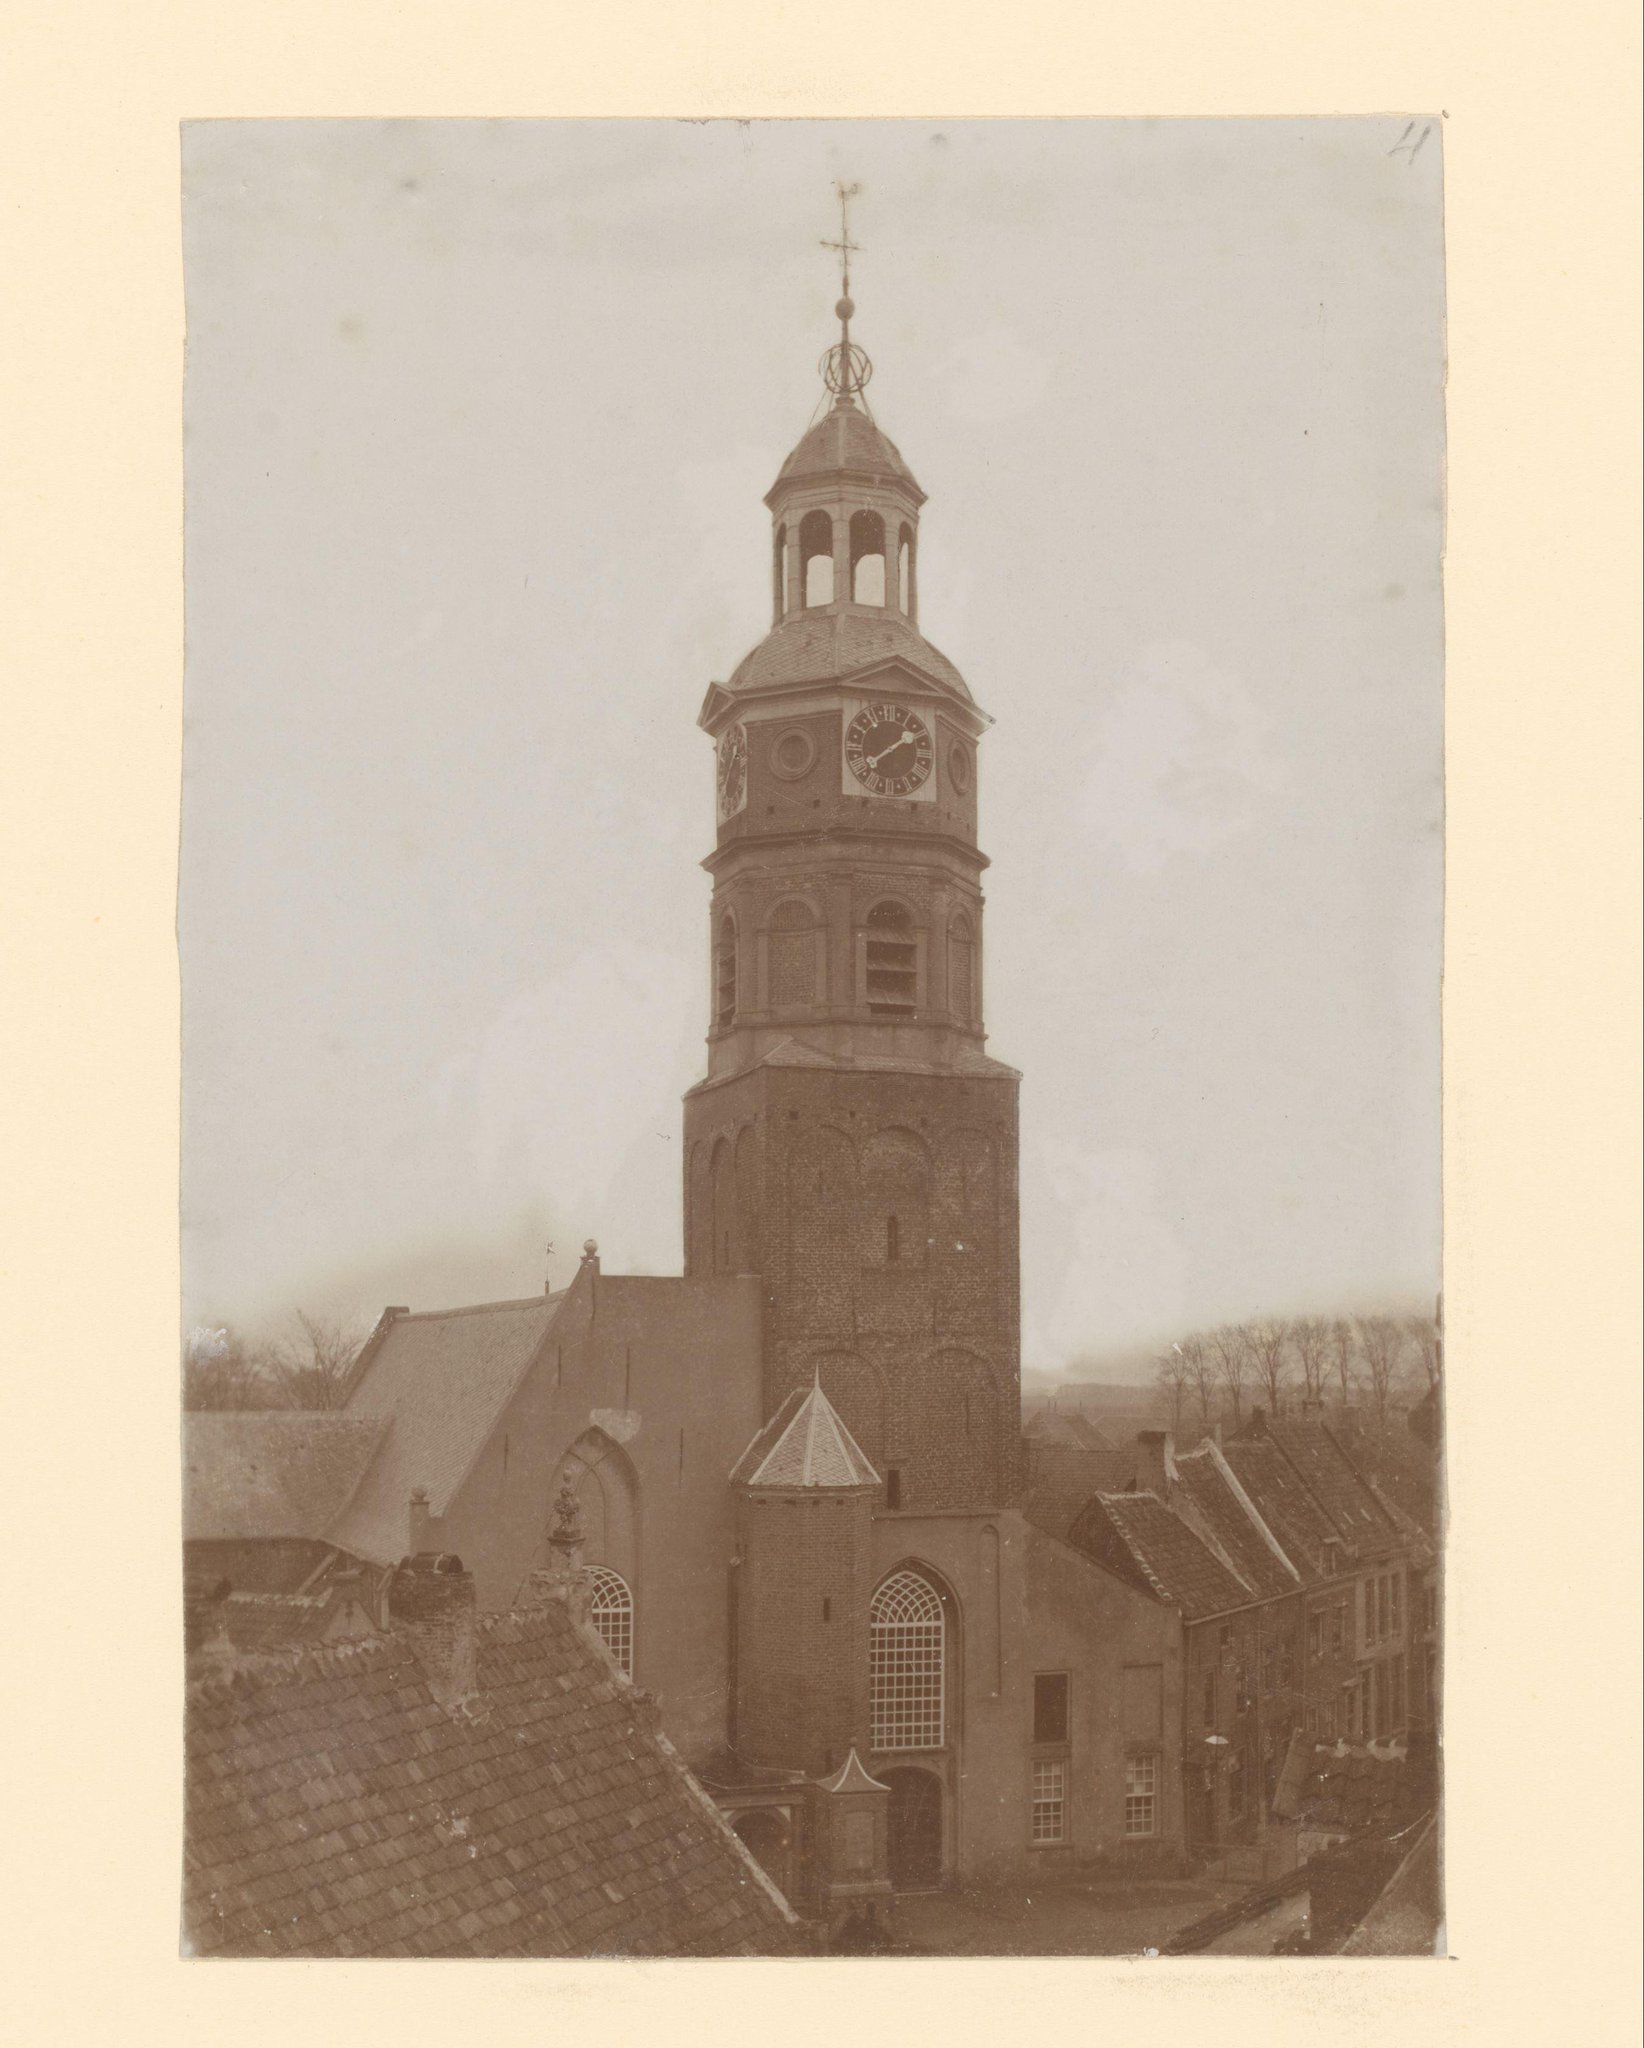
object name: photograph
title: Toren van de Sint-Lambertuskerk te Buren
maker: Anonymous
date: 1890-1920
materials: cardboard, photographic support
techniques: collodion silver print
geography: buren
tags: parts of church exterior and annexes: tower, buren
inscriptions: annotation: ‘N.H. Kerk/ Buren’, annotation: ‘Toren v/d Ned Herv. gem/ te Buren (H. Lambertus)’